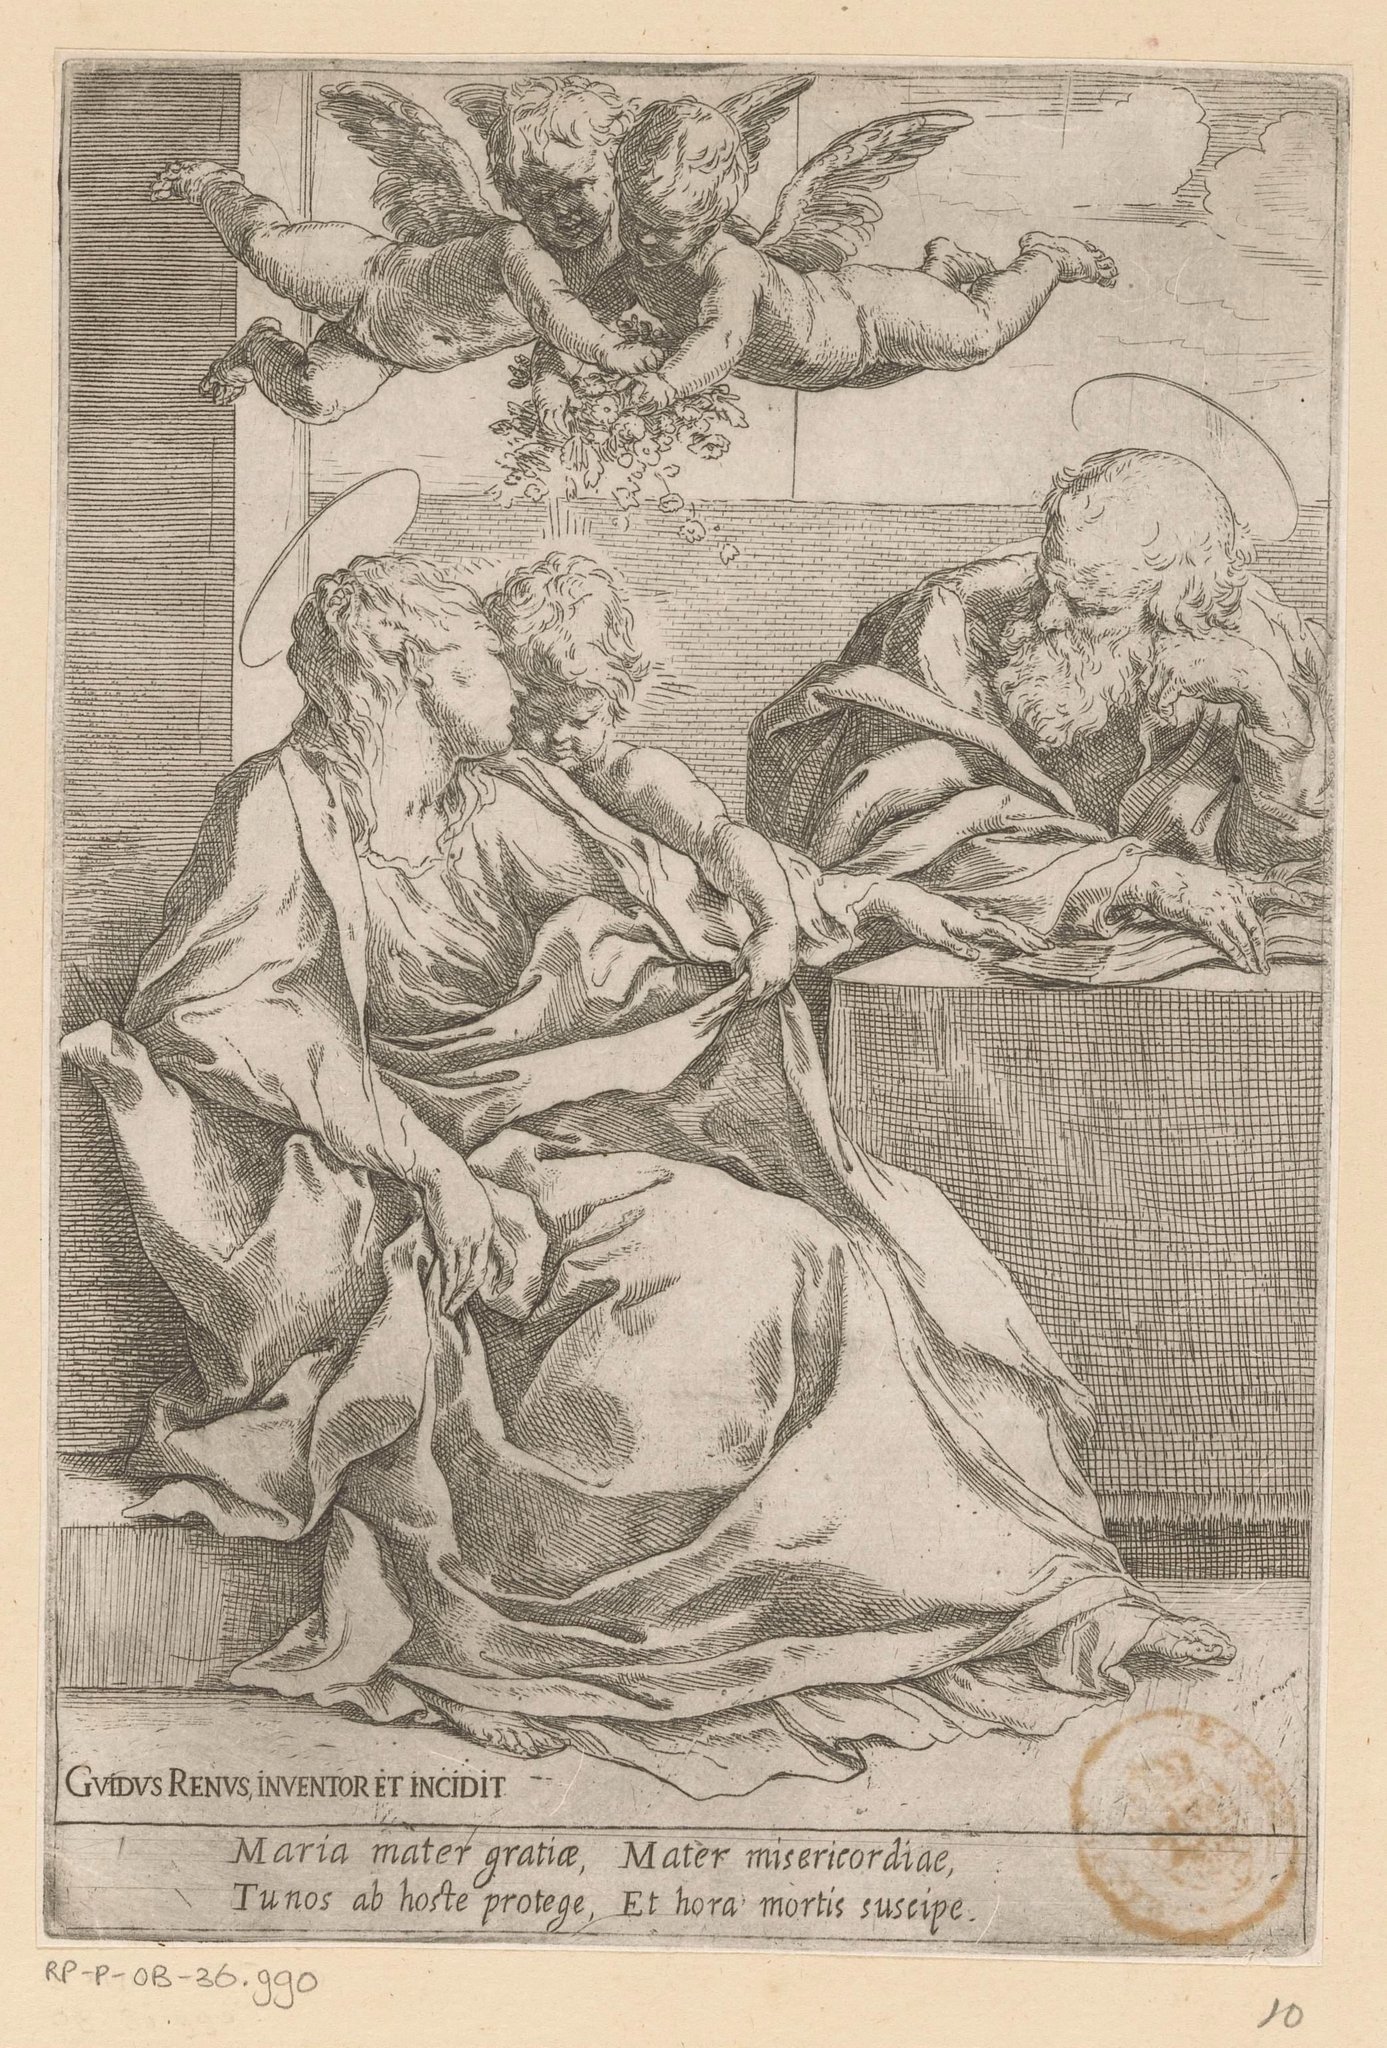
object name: print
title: Heilige Familie met twee engelen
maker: guido reni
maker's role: draughtsman, painter, print maker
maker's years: 1575-1642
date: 1585-1642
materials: paper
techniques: etching, intaglio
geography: italy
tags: holy family, and derived representations, cupids: 'amores', 'amoretti', 'putti'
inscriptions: collector's mark: Lugt 240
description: Het Christuskind leunt tegen de schouder van Maria. Rechts zit Jozef. Boven zweven twee putti die bloemen strooien over het Kind. Vers in het Latijn in ondermarge.